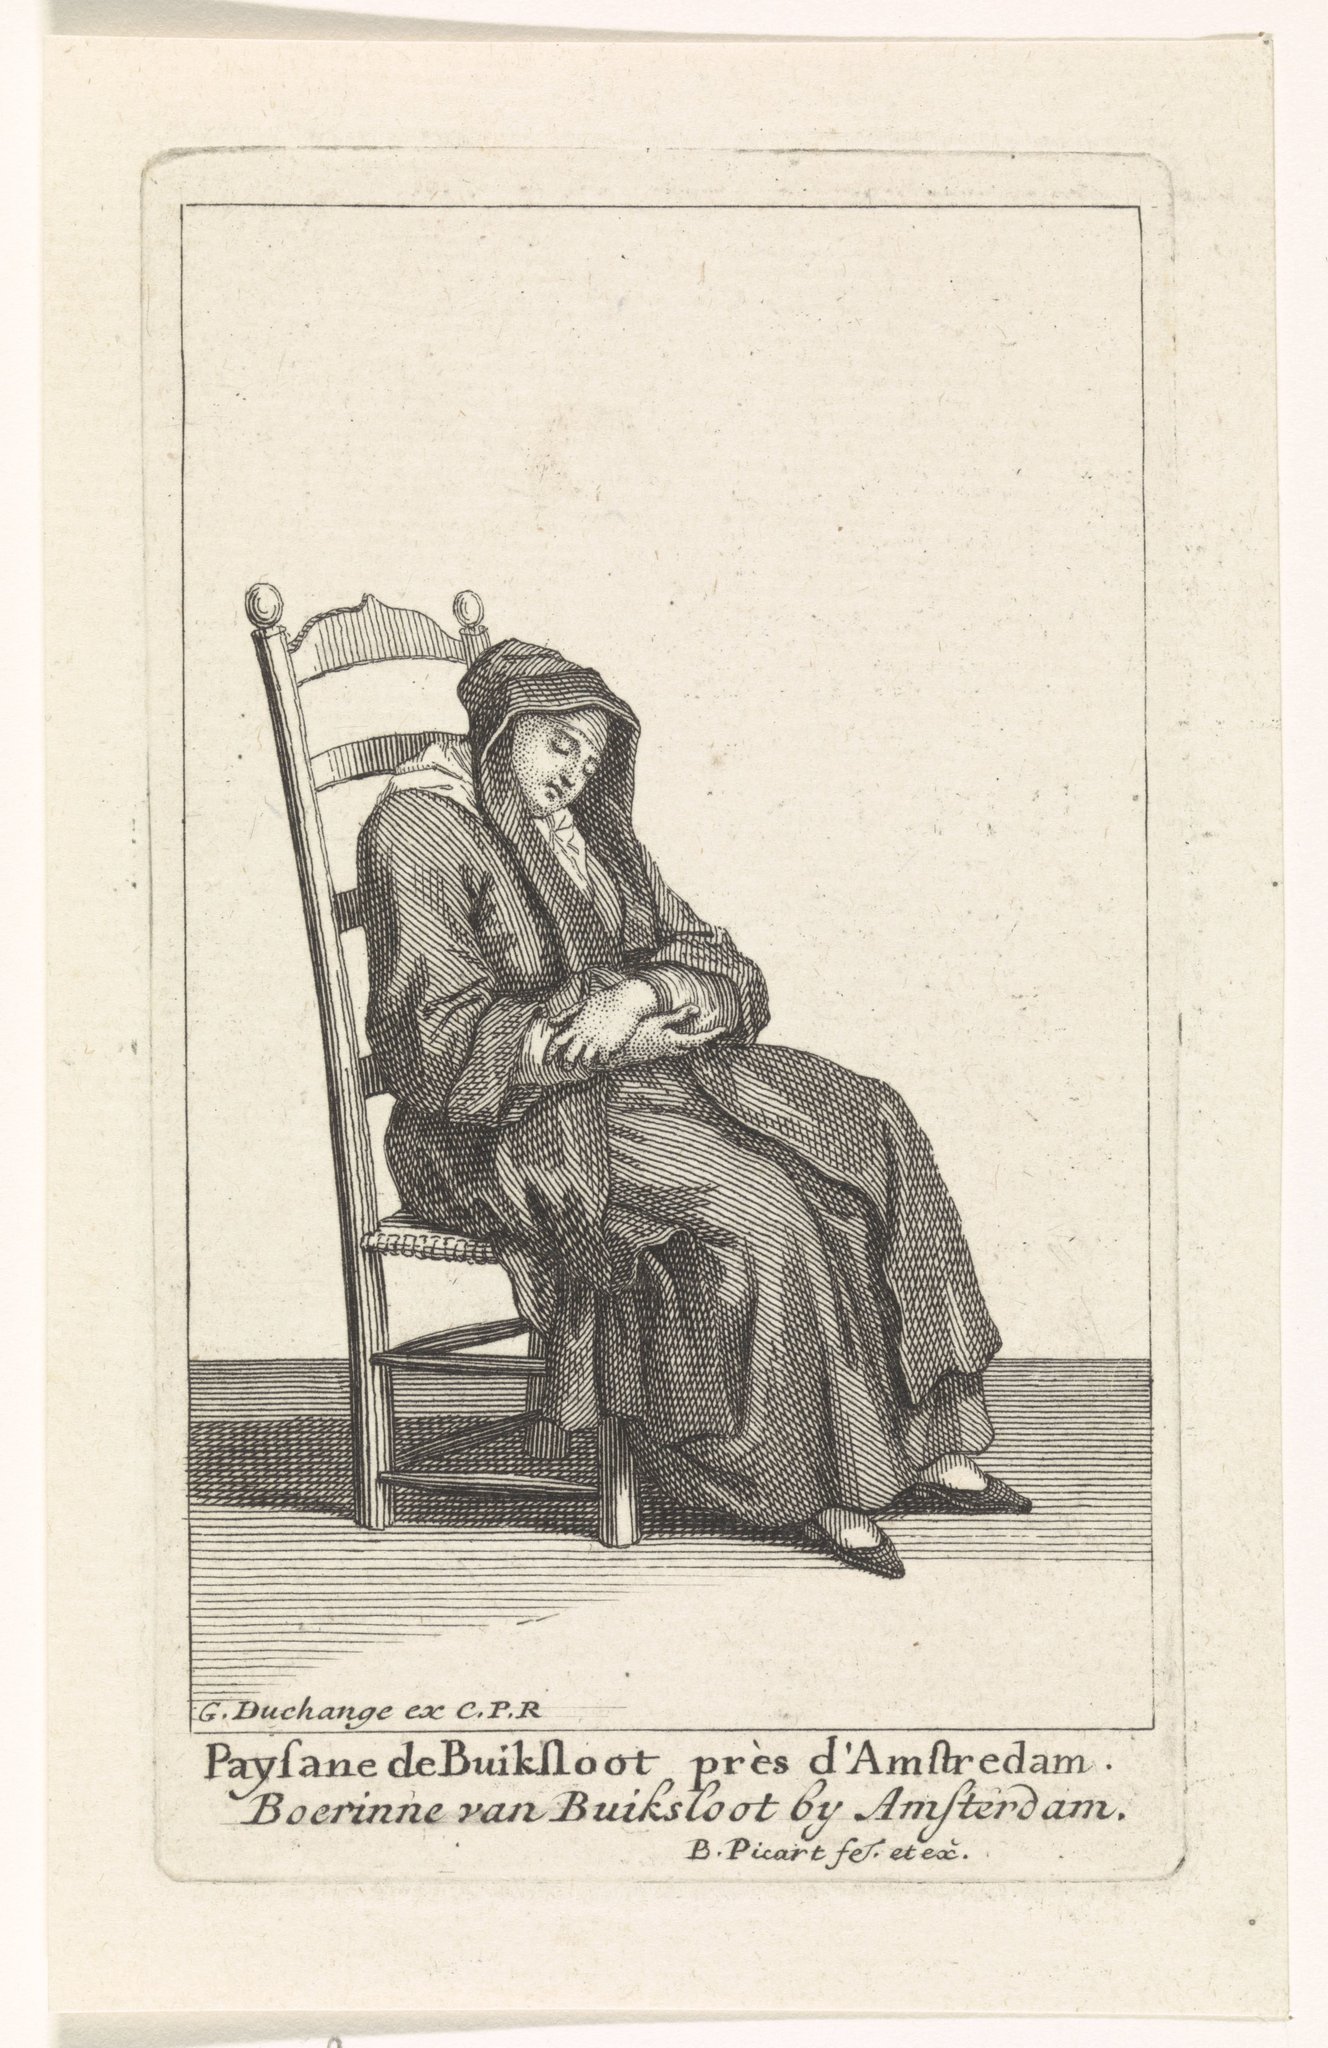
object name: costume print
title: Boerin uit Buiksloot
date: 1728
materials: paper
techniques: engraving, etching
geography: amsterdam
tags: folk costume, regional costume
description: Figuur in klederdracht. De vrouw slaapt op een stoel. De prent heeft een titel in het Frans en in het Nederlands.